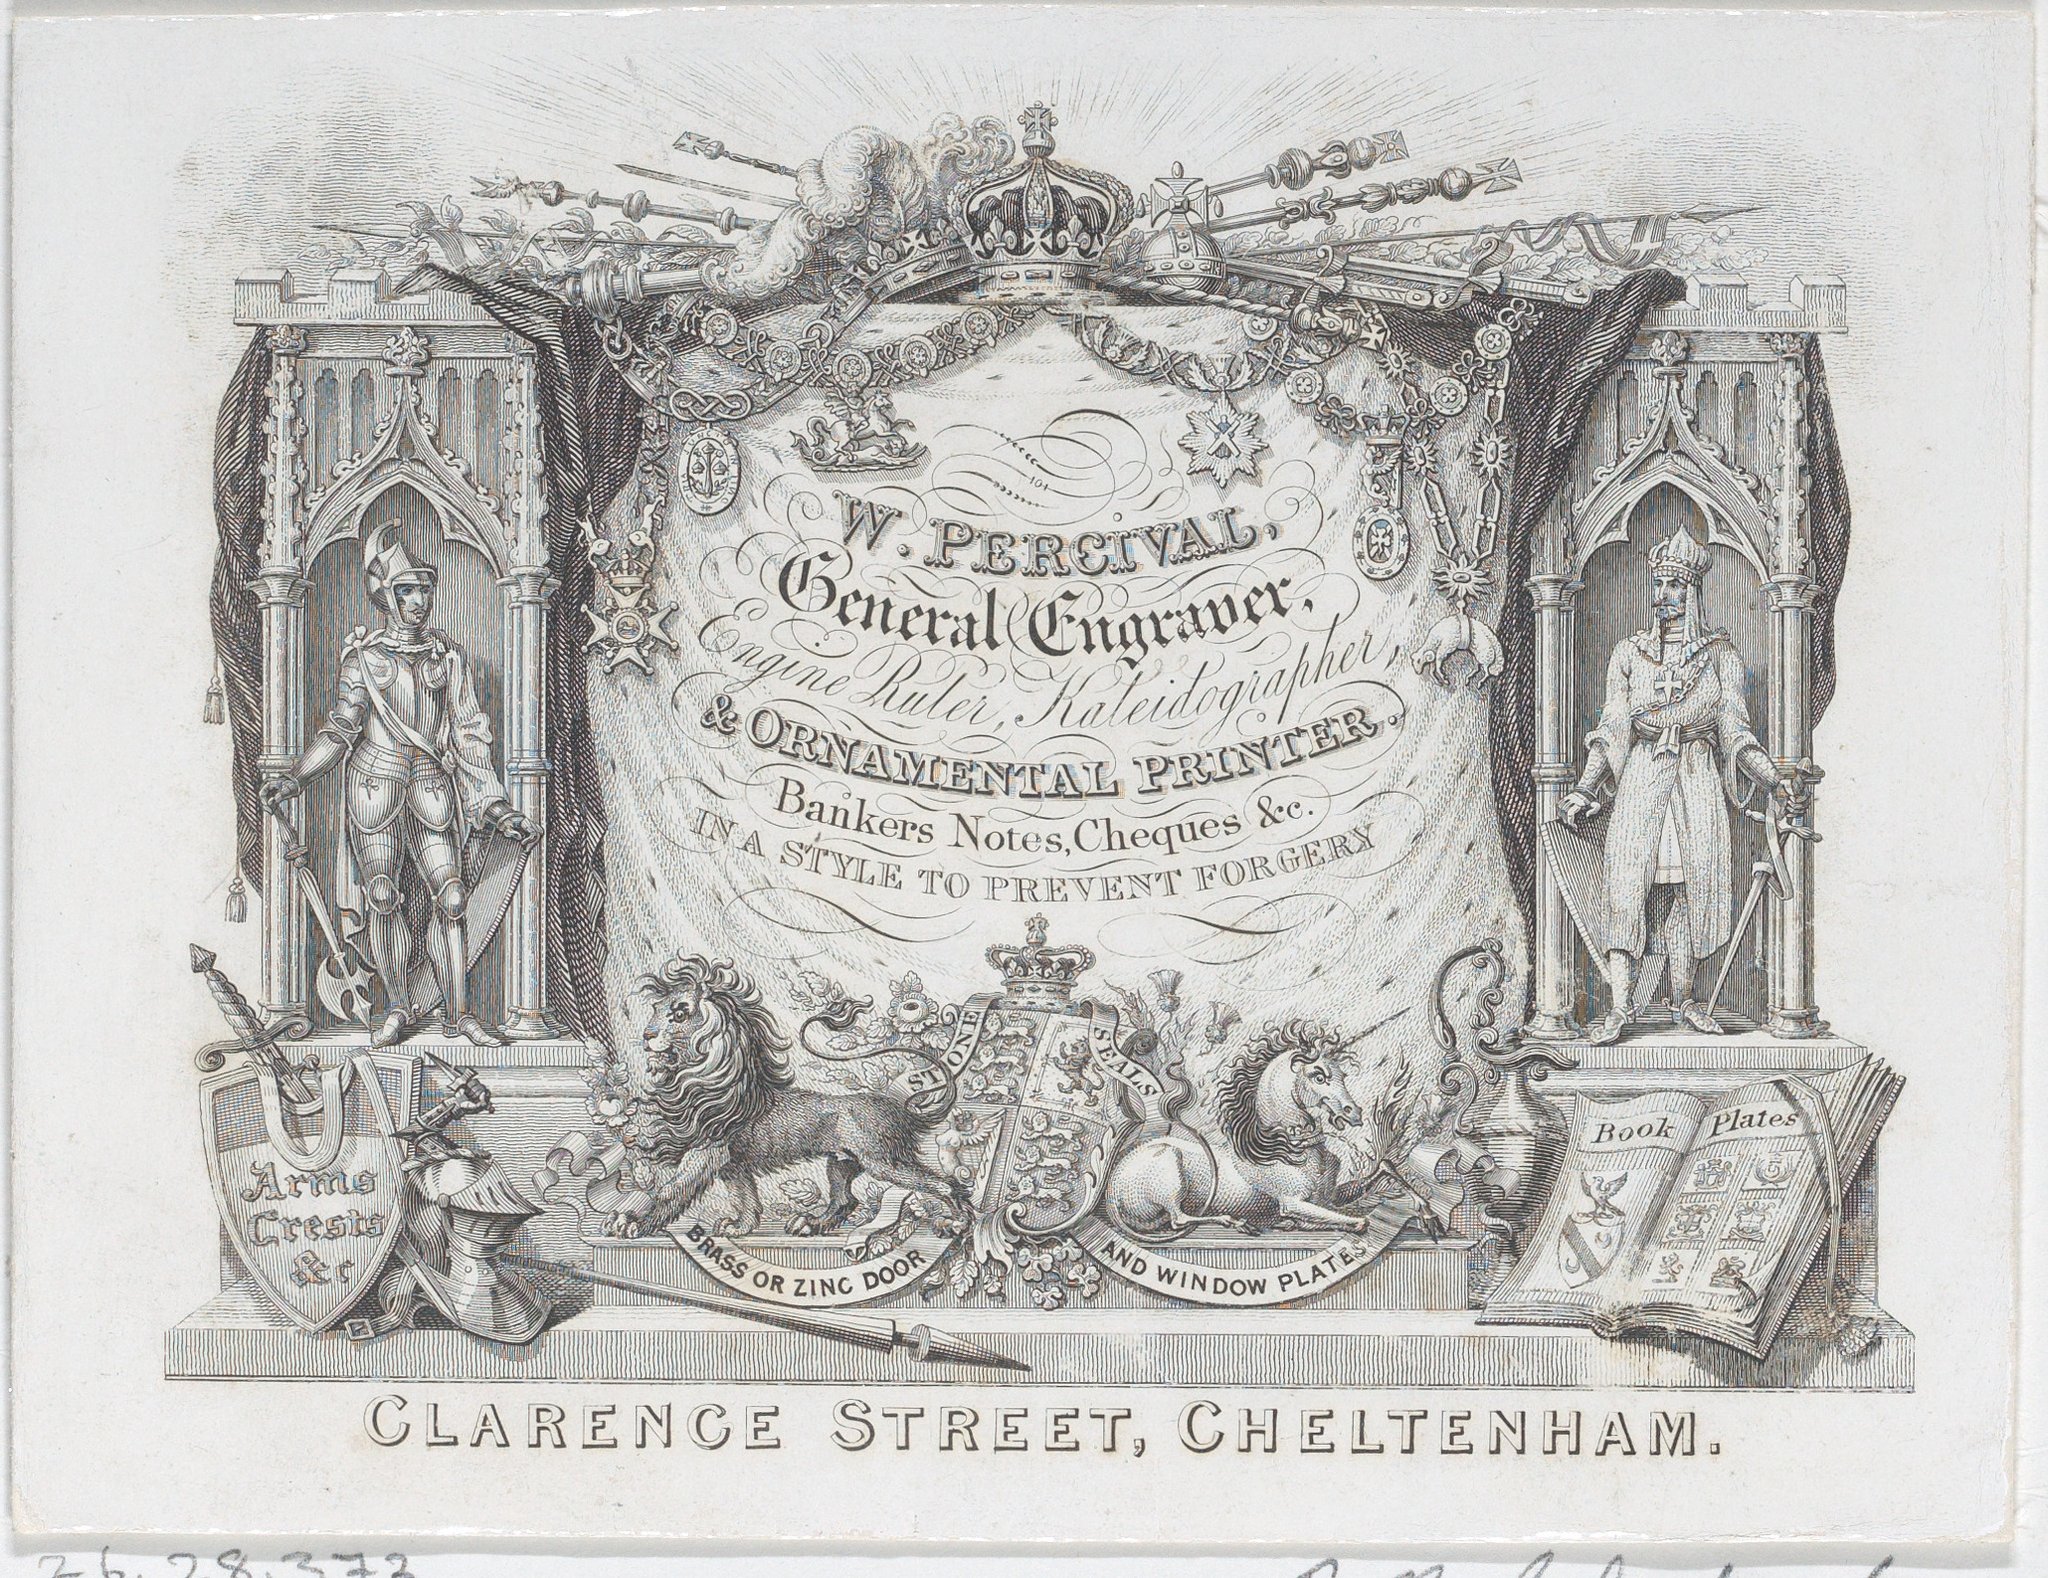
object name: print, trade card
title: Trade Card for W. Percival, General Engraver & Ornamental Printer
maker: anonymous, british, 19th century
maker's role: artist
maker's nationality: british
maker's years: 1800-1900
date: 1801-1900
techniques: engraving, etching